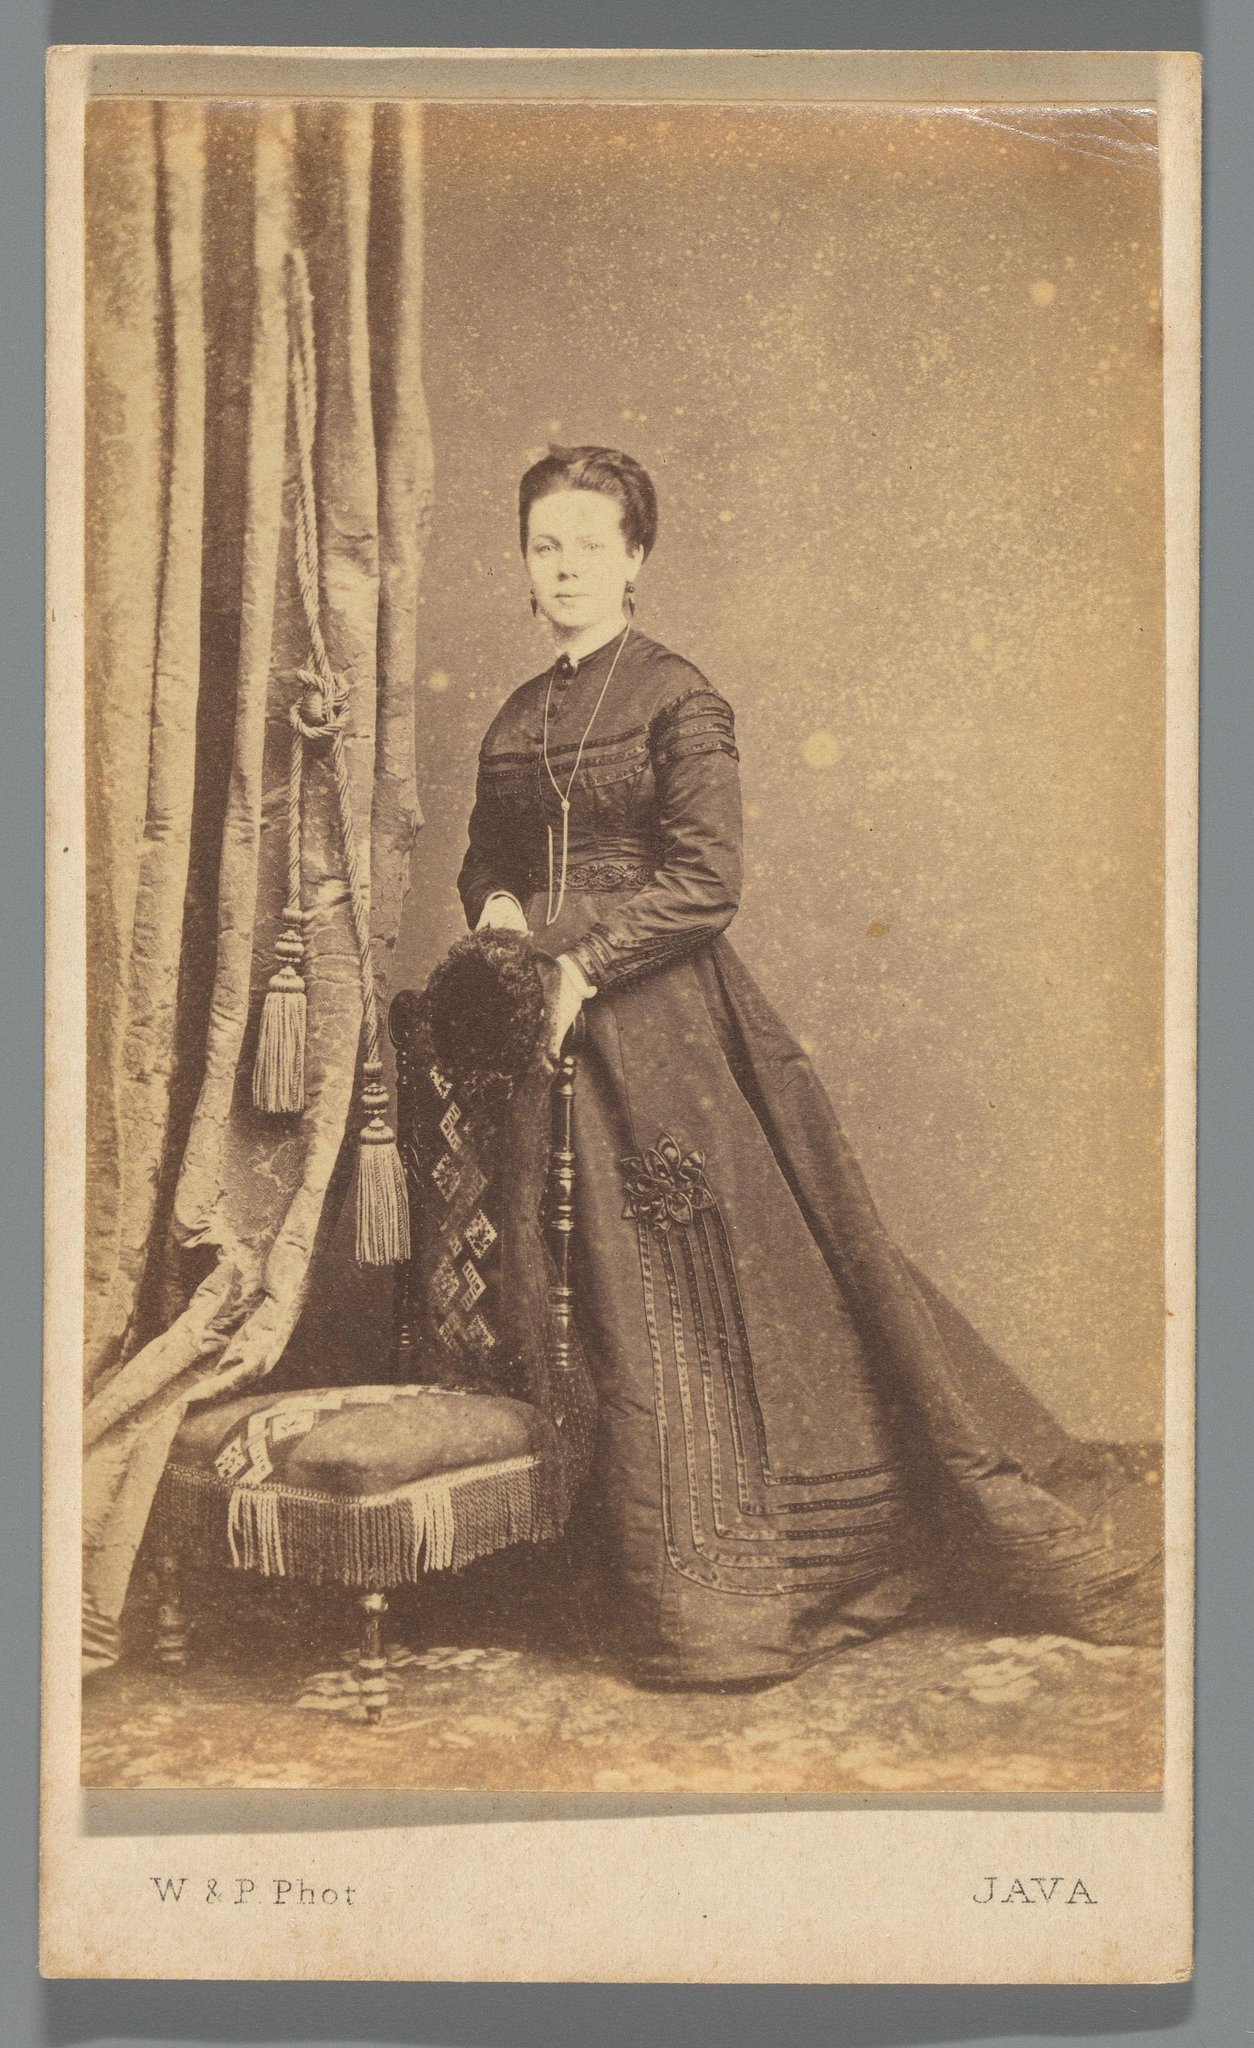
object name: carte de visite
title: Studioportret van Carolina Frederika Holle staand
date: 1855-1910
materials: cardboard, photographic support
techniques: albumen print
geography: java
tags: amsterdam, carolina frederika van den berg-holle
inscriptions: name: ‘WOODBURY & PAGE , / PHOTOGRAPHERS / JAVA.’, name: ‘W. & P. Phot. JAVA’, name: ‘C.F. vandenBerg / Holle’